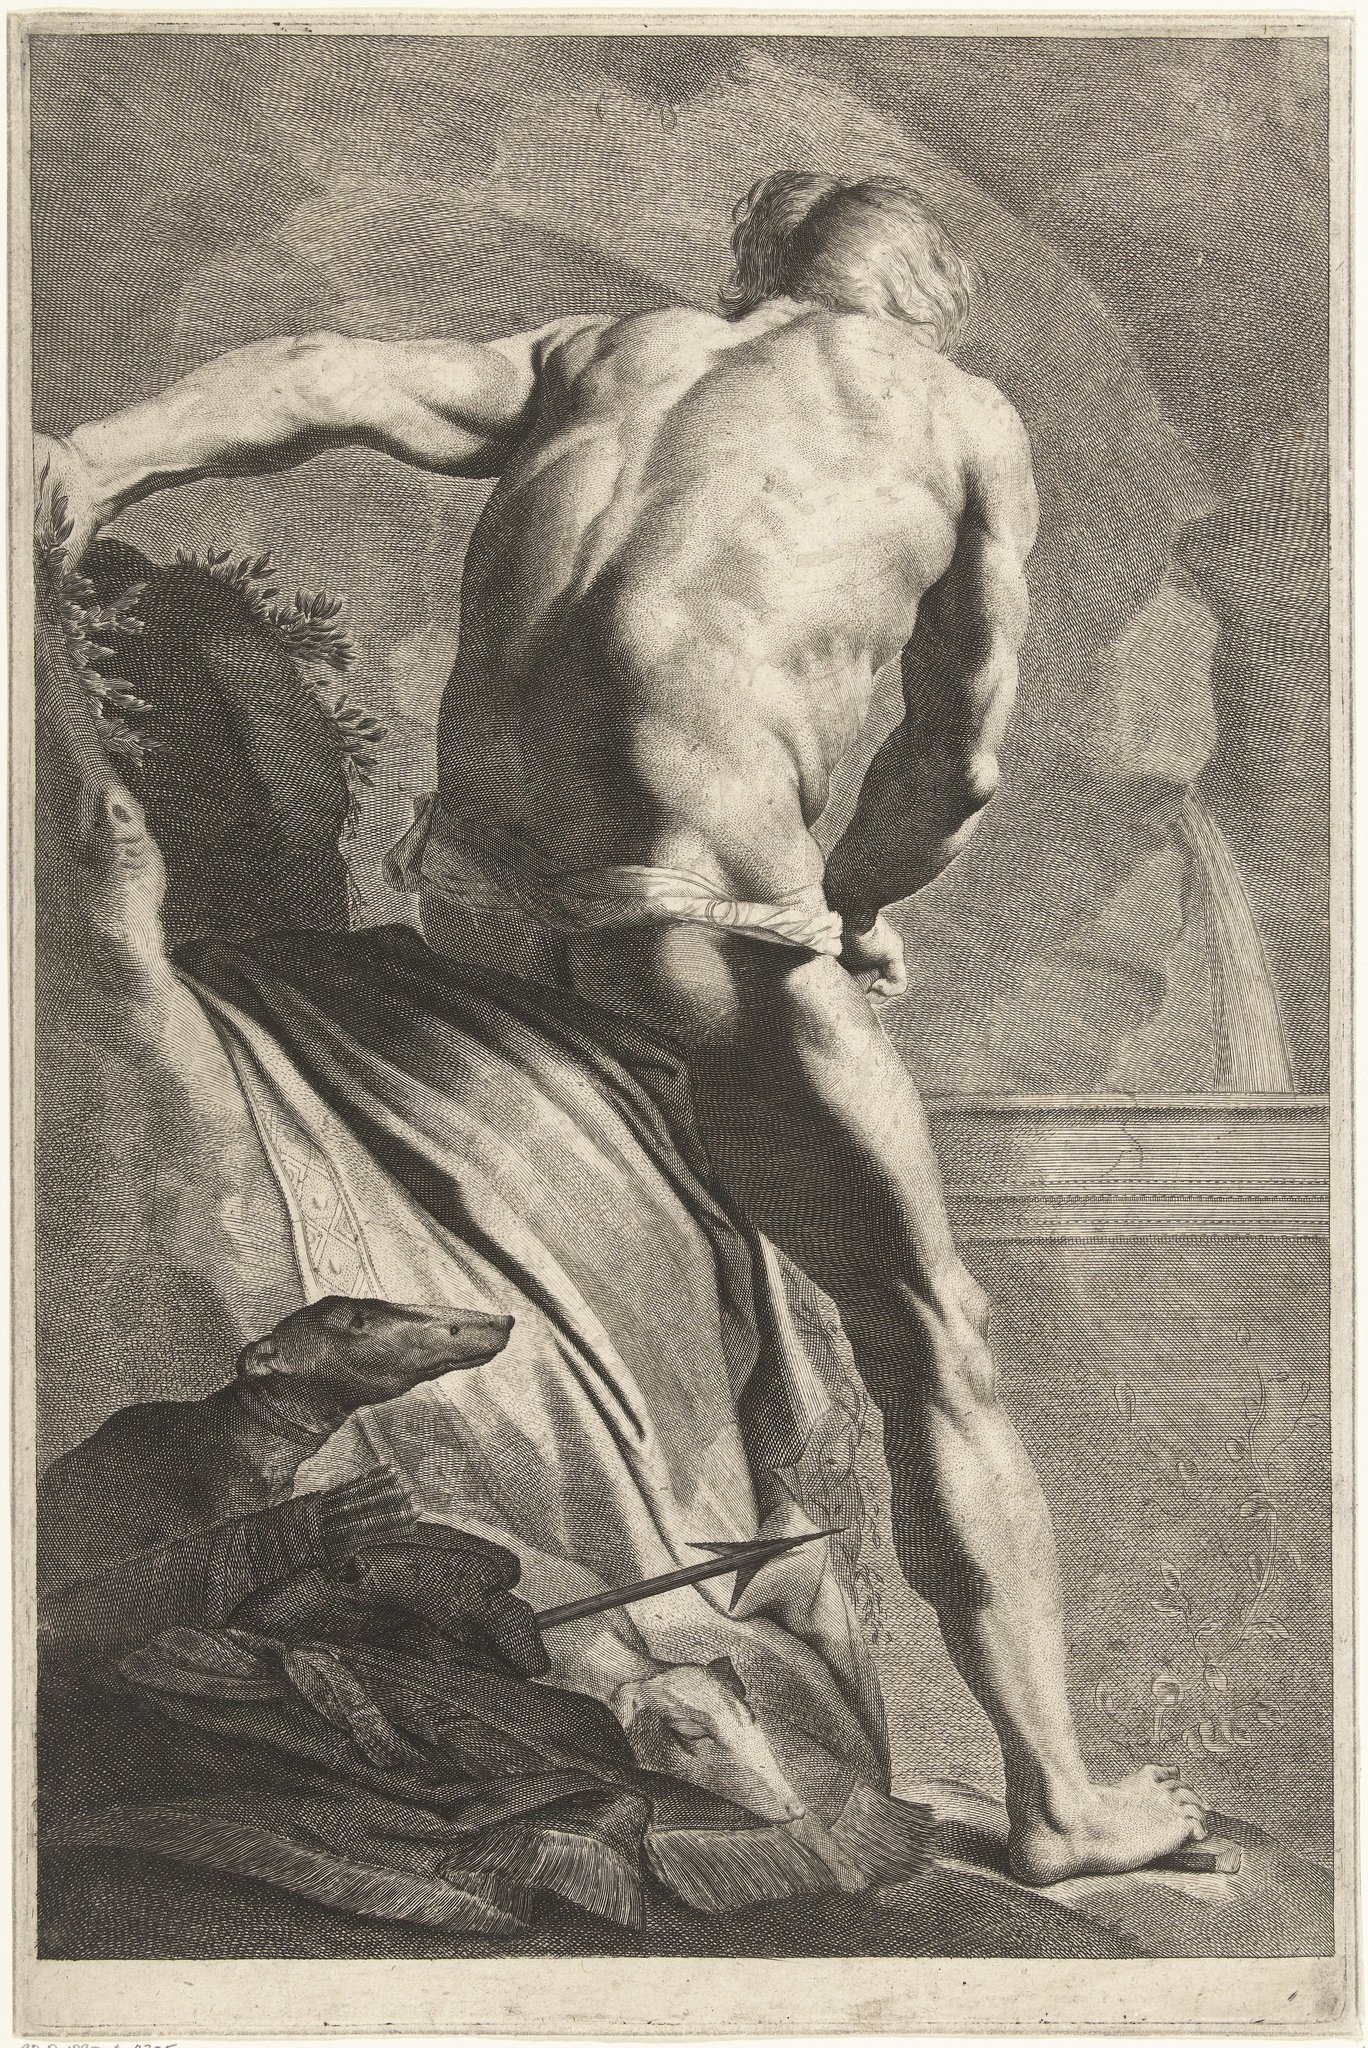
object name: print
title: Narcissus bij fontein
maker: cornelis van dalen (ii)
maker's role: draughtsman, print maker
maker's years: 1638-1664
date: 1648-1664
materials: paper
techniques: engraving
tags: (story of) narcissus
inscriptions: collector's mark: Lugt 2228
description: Vrijwel naakte Narcissus op de rug gezien zittend op rotsen bij fontein. Bij zijn voeten liggen twee honden en een pijlenkoker.